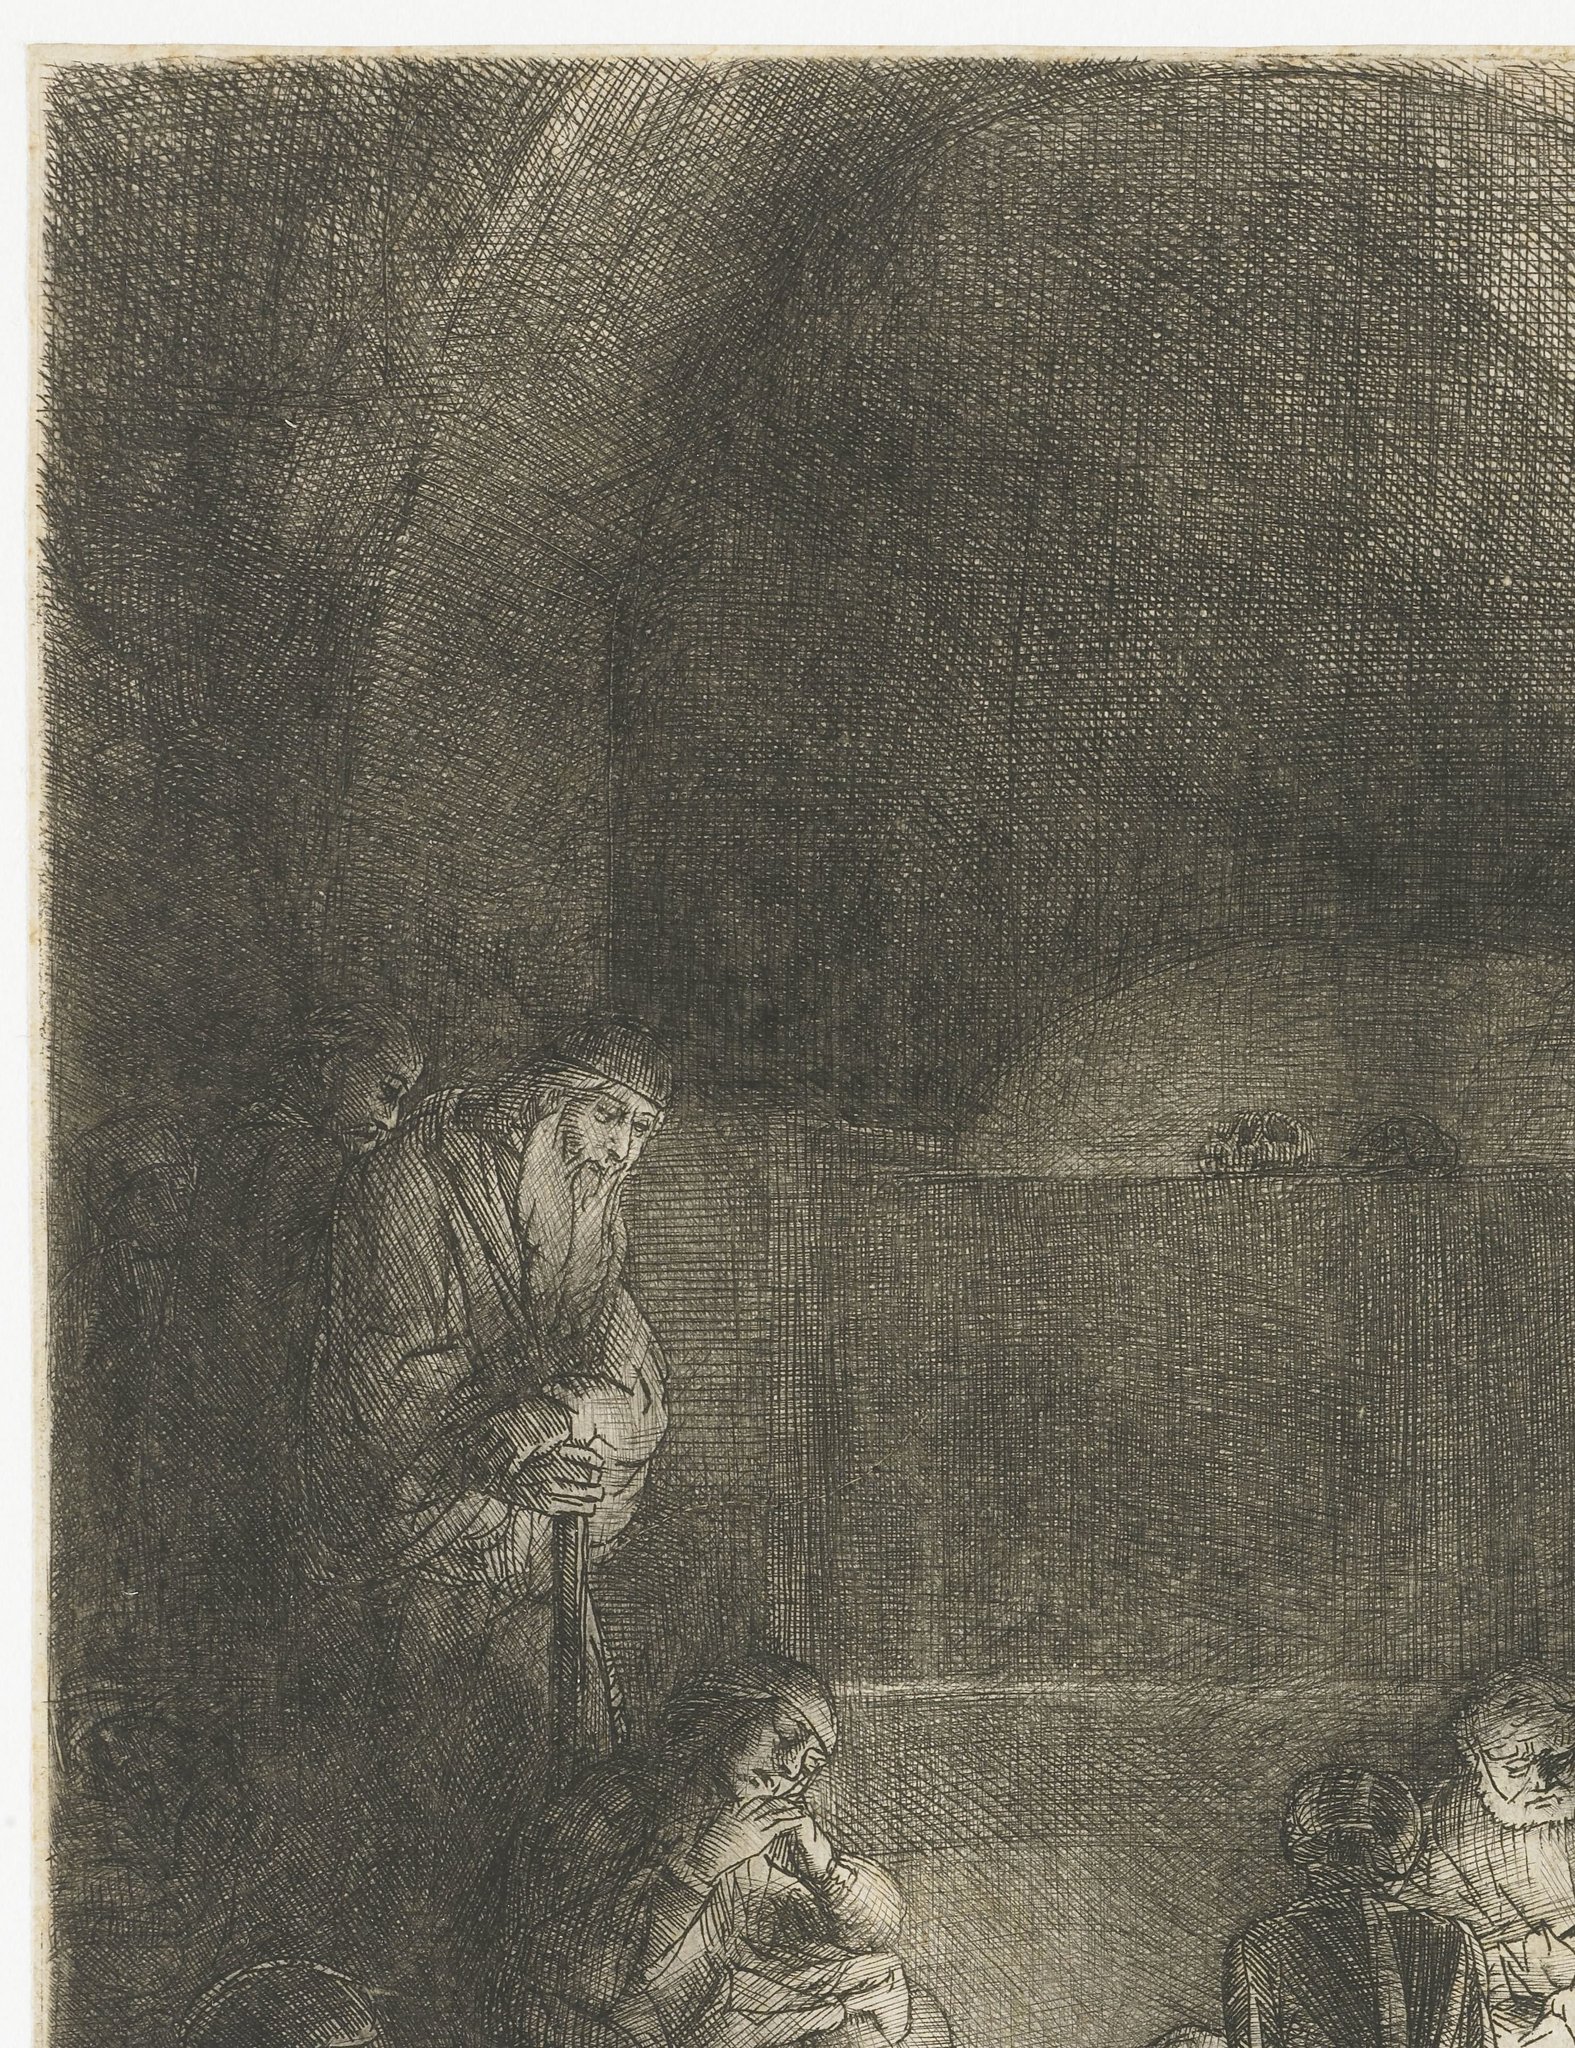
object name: print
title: The Entombment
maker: rembrandt van rijn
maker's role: draughtsman, painter, print maker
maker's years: 1606-1669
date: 1654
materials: paper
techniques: drypoint, etching, intaglio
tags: christ's entombment (possibly by angels)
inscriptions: collector's mark: Lugt 109, collector's mark: Lugt 2228, collector's mark: ‘F.D. 1843.’ Lugt 985